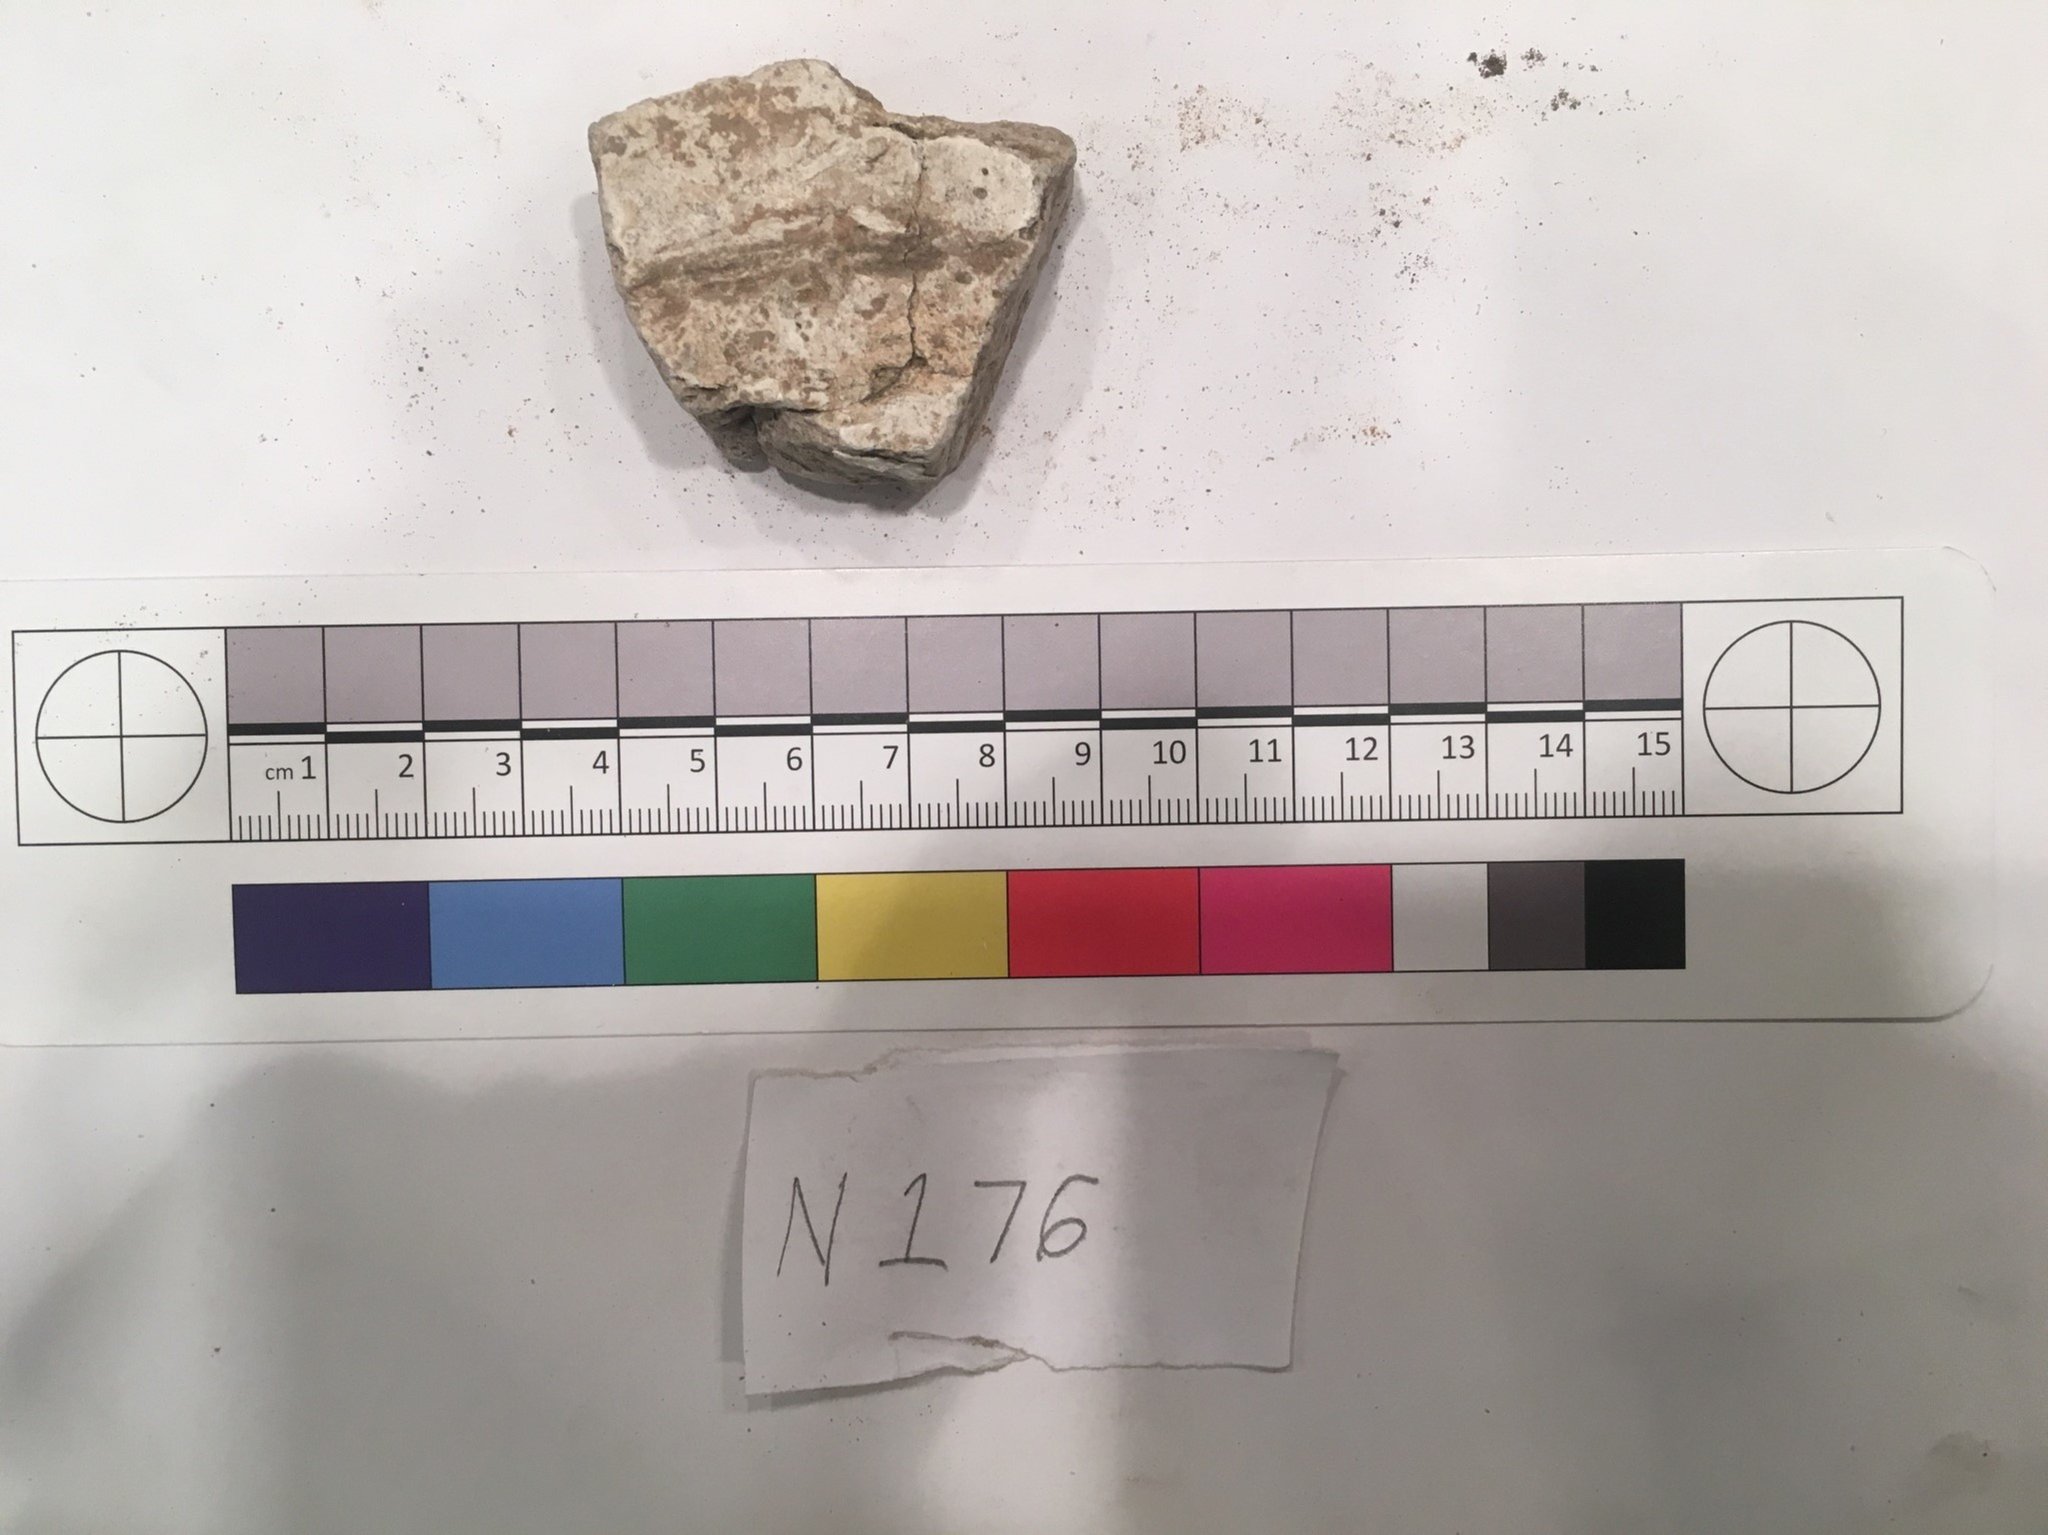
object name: fragment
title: Stucco Fragment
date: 701-1200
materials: plaster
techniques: carving, painting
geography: iran